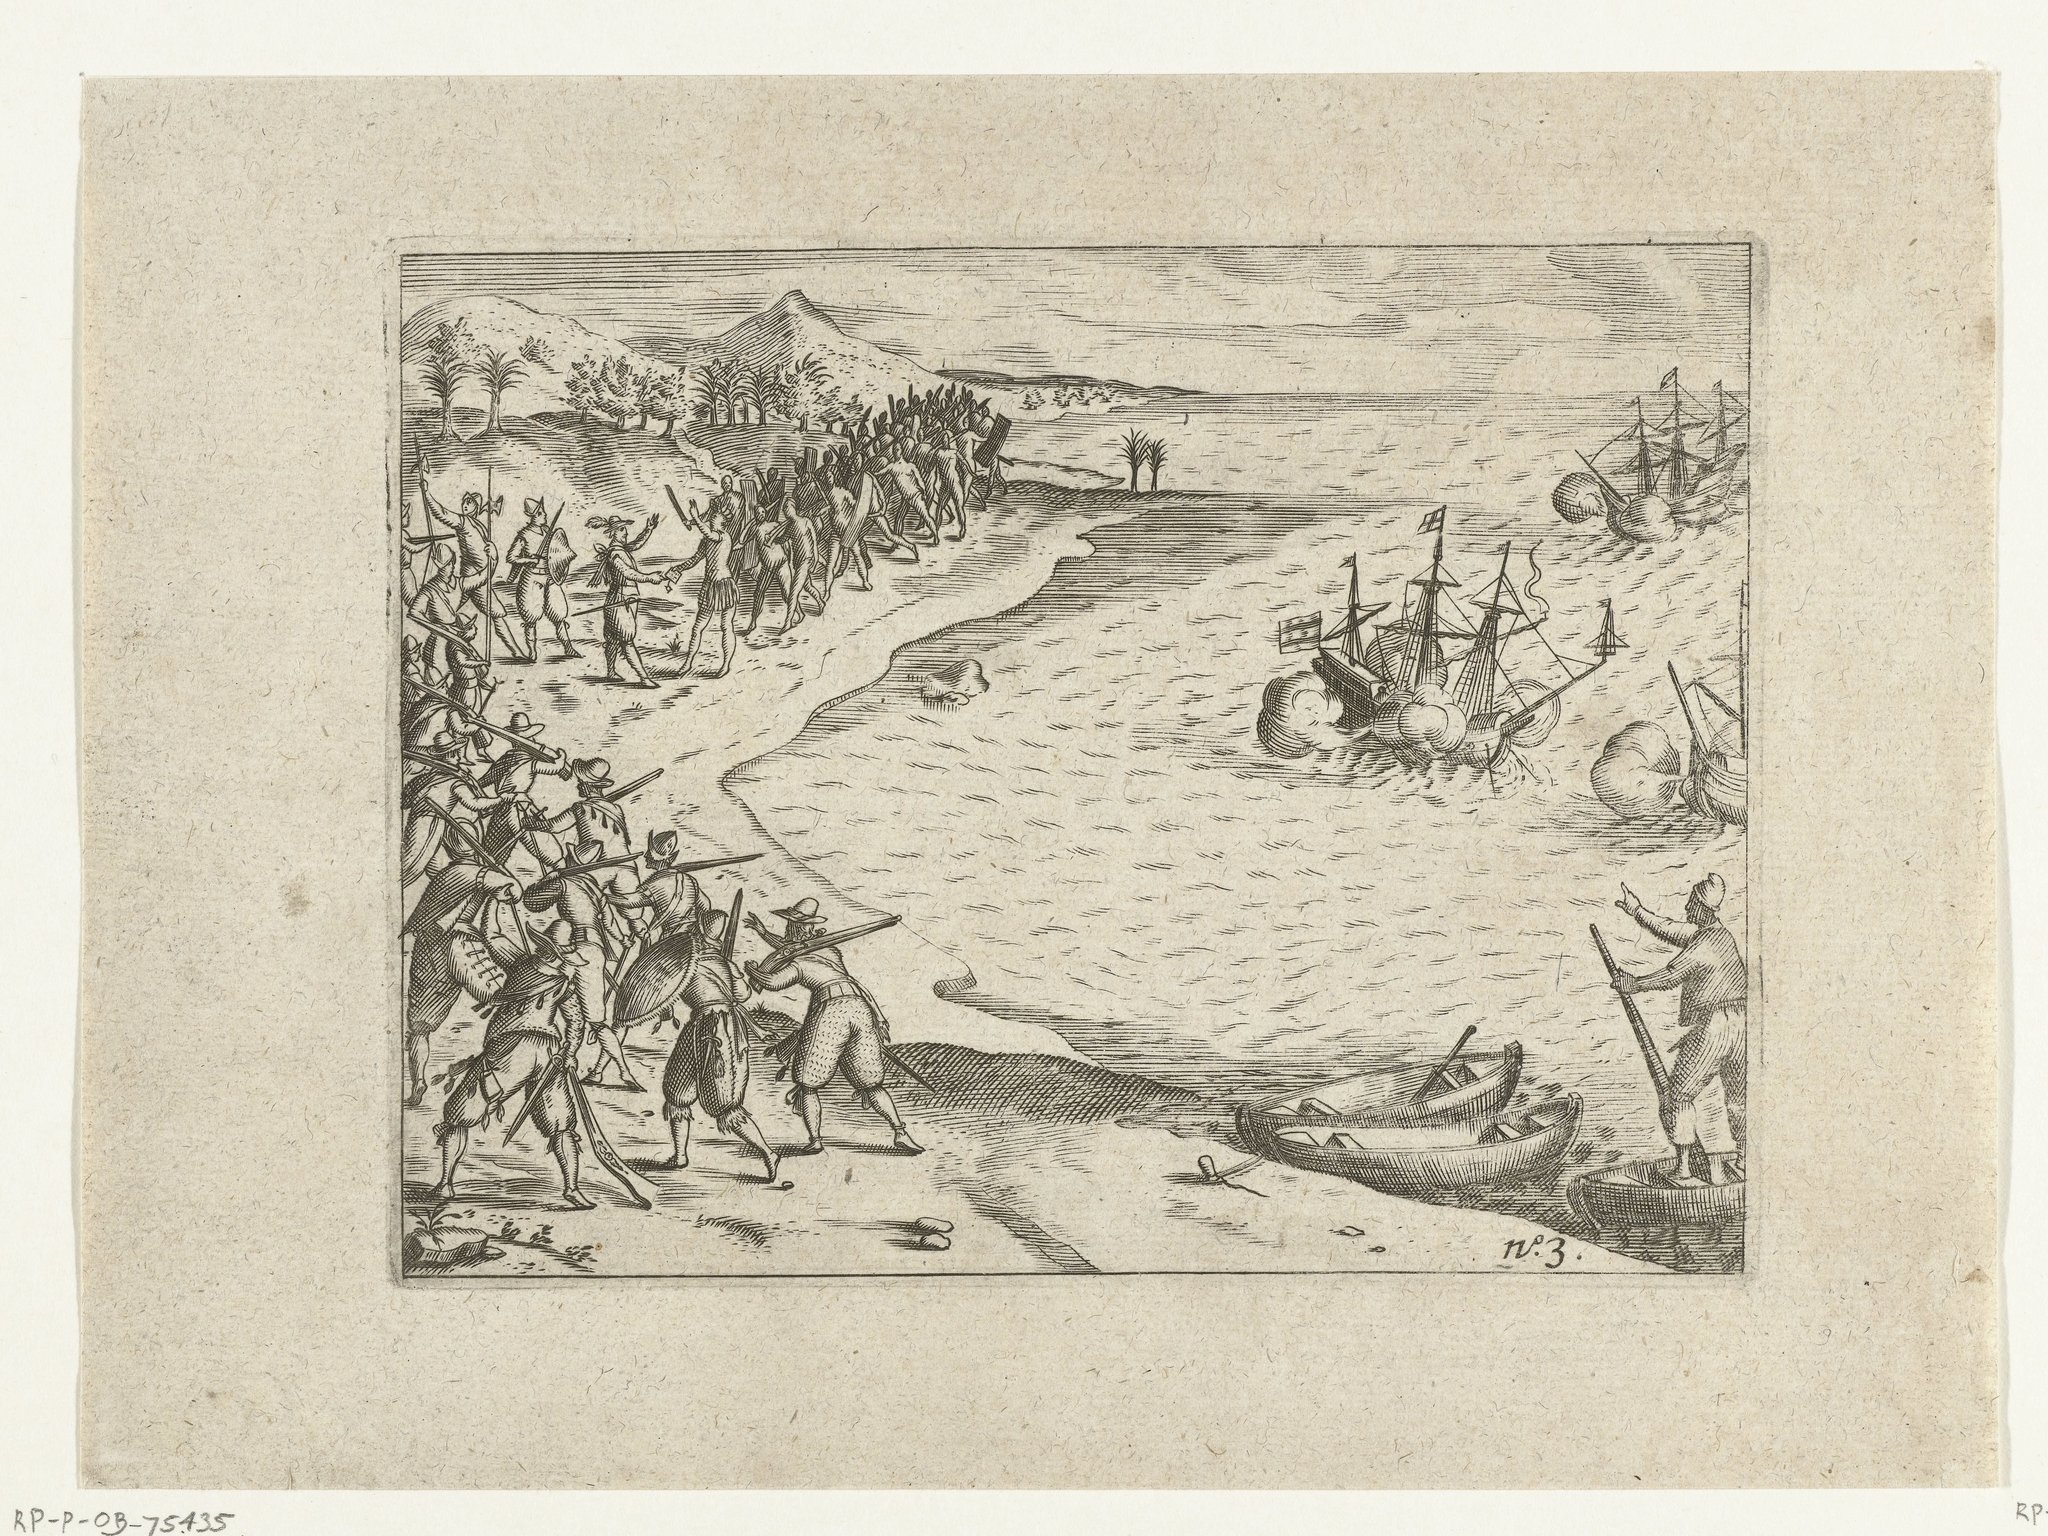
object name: print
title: Ontvangst van de Hollanders door de Samorin van Calicut, 1604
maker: Anonymous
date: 1644-1646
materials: paper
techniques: engraving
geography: northern netherlands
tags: landscapes in tropical and sub-tropical regions, exploration, expedition, voyage of discovery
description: De oorspronkelijke platen eerst gebruikt in: Kort en¯ warachtich verhael vande heerlicke victorie (...) by de twaelf schepen afghevaren uyt Hollandt, ondert' ghebiedt vanden generael (...) Steven Verhaghen, in de eylanden vande Moluckes (Jan Jansz, Rotterdam, 1606) in de uitgave van De Bry, Petits Voyages, 1607. Deze kopieën gebruikt in: Beschrijvinghe van de tweede Voyagie, Ghedaen met 12. Schepen naer d'Oost-Indien. Onder den Heer Admirael Steven vander Hagen. Deze tekst opgenomen in : I. Commelin, Begin ende voortgangh, van de Vereenighde Nederlantsche Geoctroyeerde Oost-Indische Compagnie, J. Janssonius, Amsterdam 1646. Genummerd: 3.